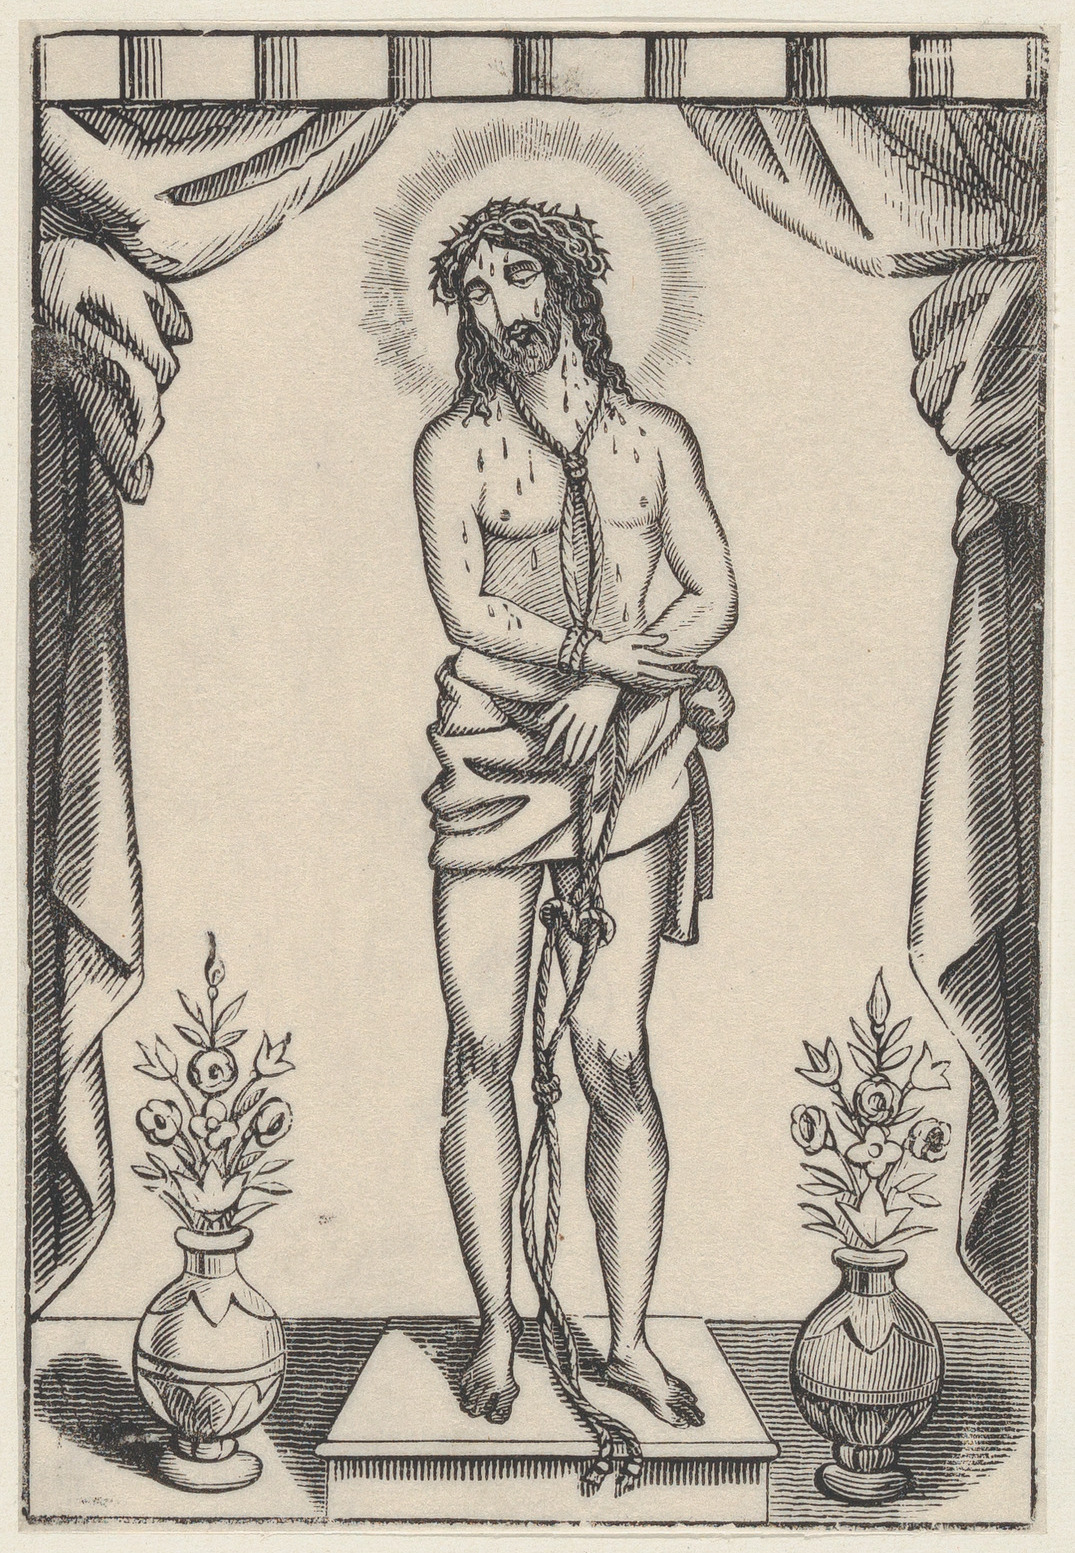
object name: print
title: Christ standing, hands tied with rope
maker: anonymous, mexican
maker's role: artist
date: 1801-1900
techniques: woodcut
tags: christ,bearing the cross